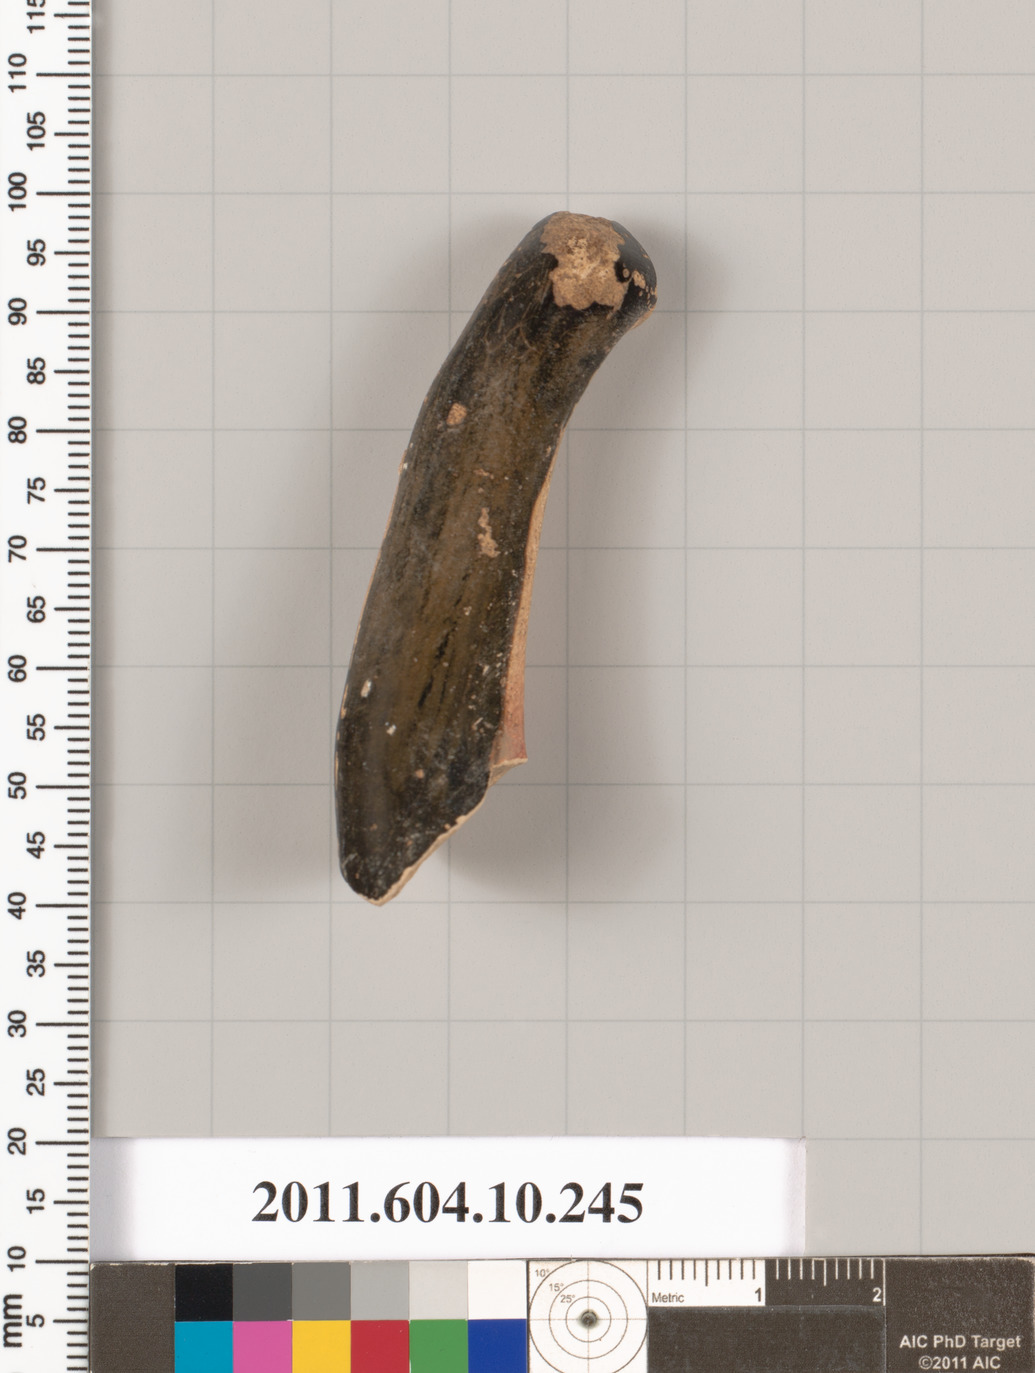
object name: kylix fragment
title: Terracotta fragment of a kylix (drinking cup)?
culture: etruscan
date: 600-401 BCE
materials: terracotta